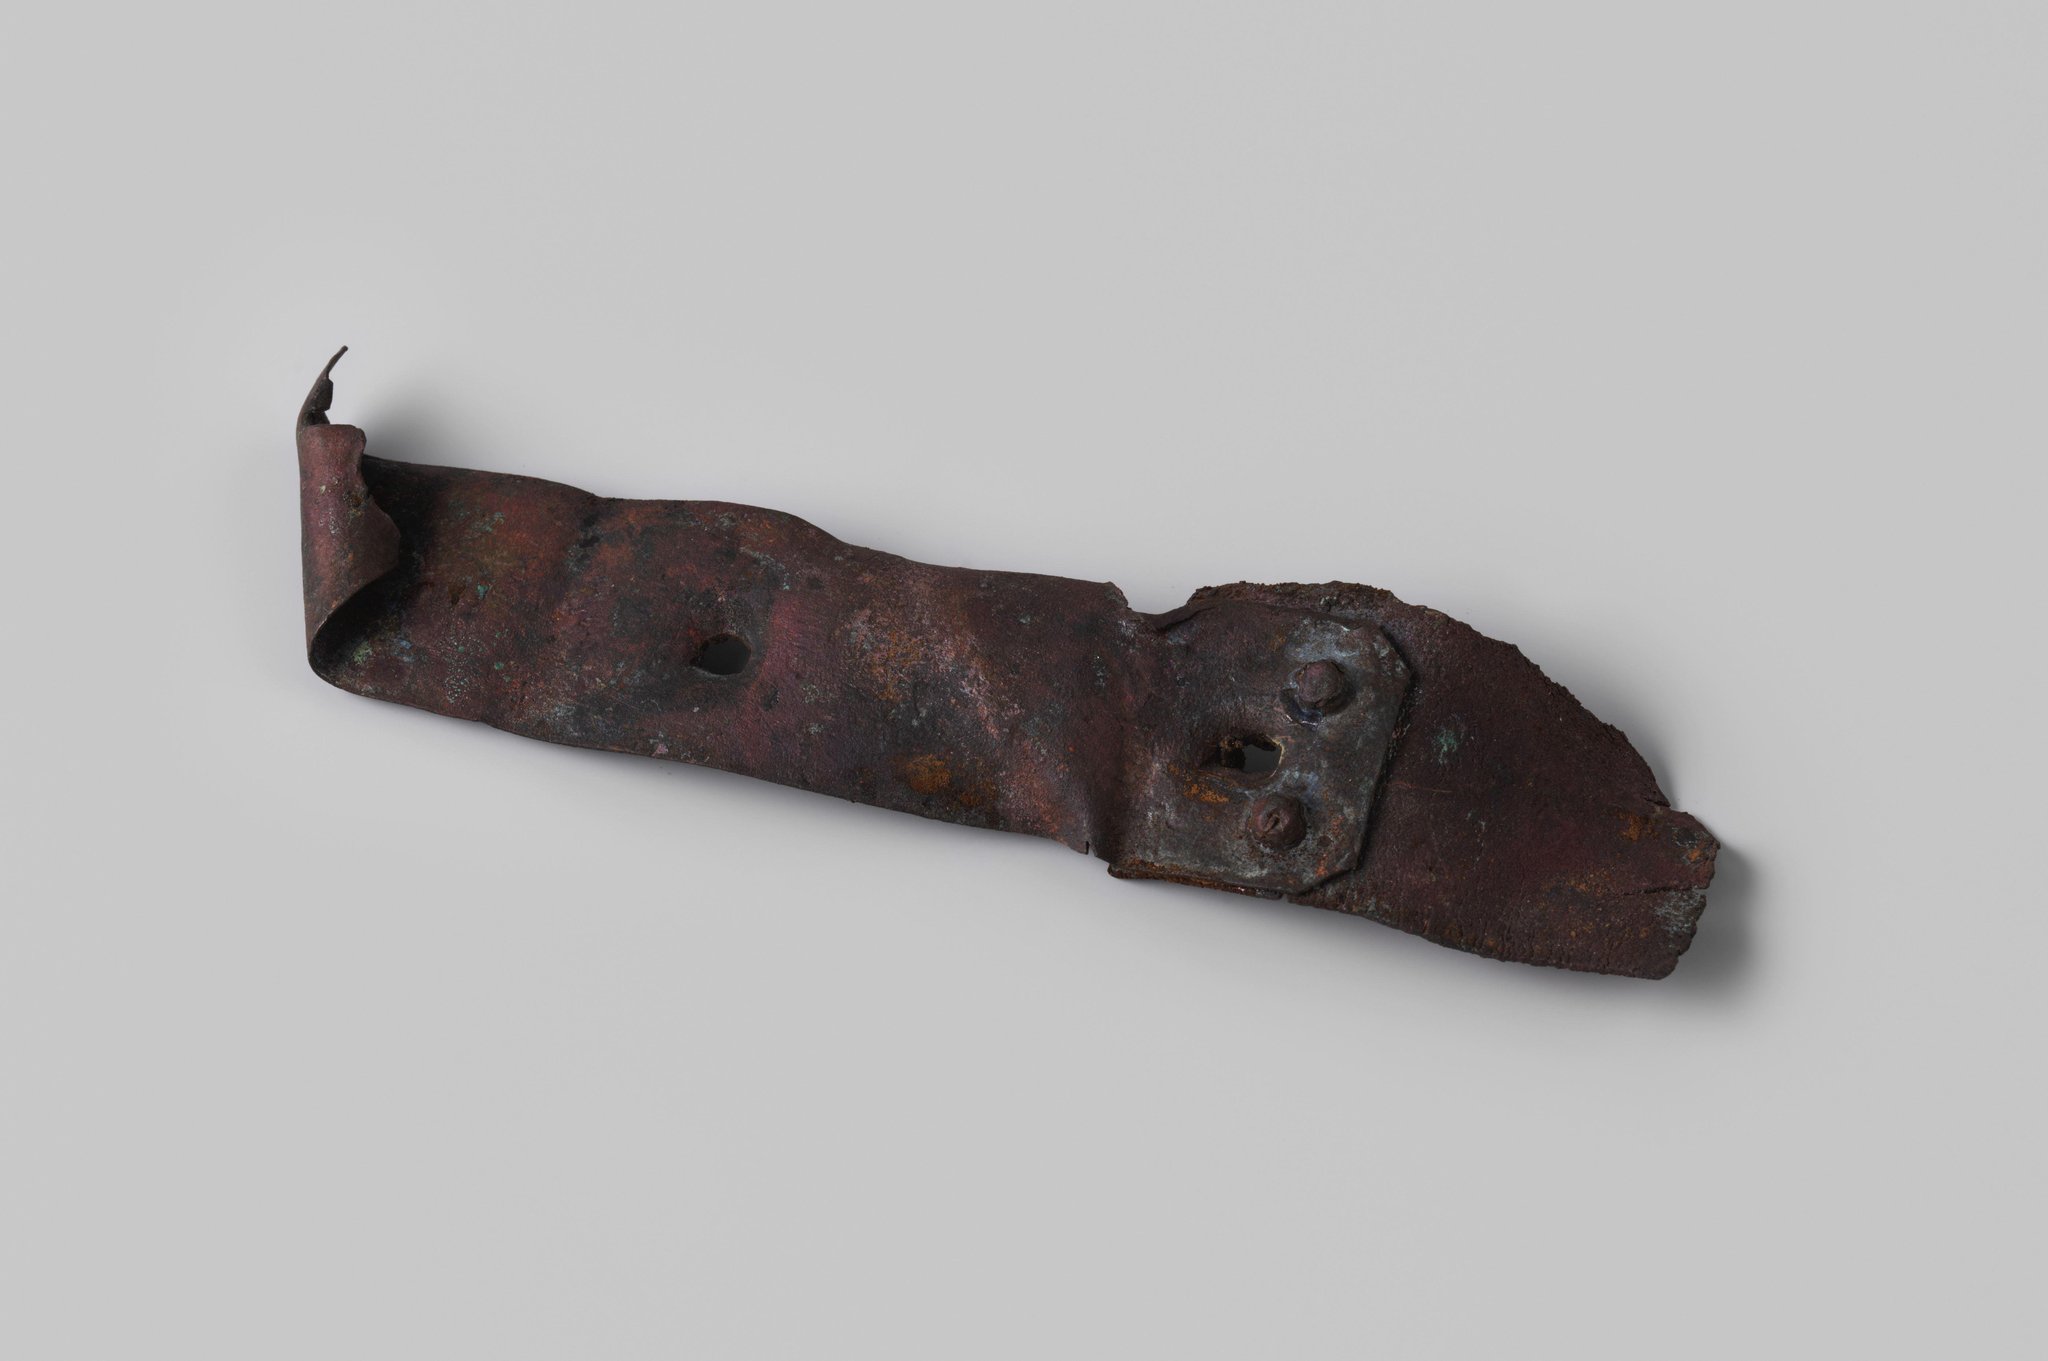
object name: fragment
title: Fragment van koperen plaatwerk uit het wrak van de Oost-Indiëvaarder Hollandia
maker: Anonymous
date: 1700-1743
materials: copper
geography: netherlands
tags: verenigde oostindische compagnie, hollandia (schip), annet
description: Varied parts or fragments, strips and strip-shaped fragments; fragm.